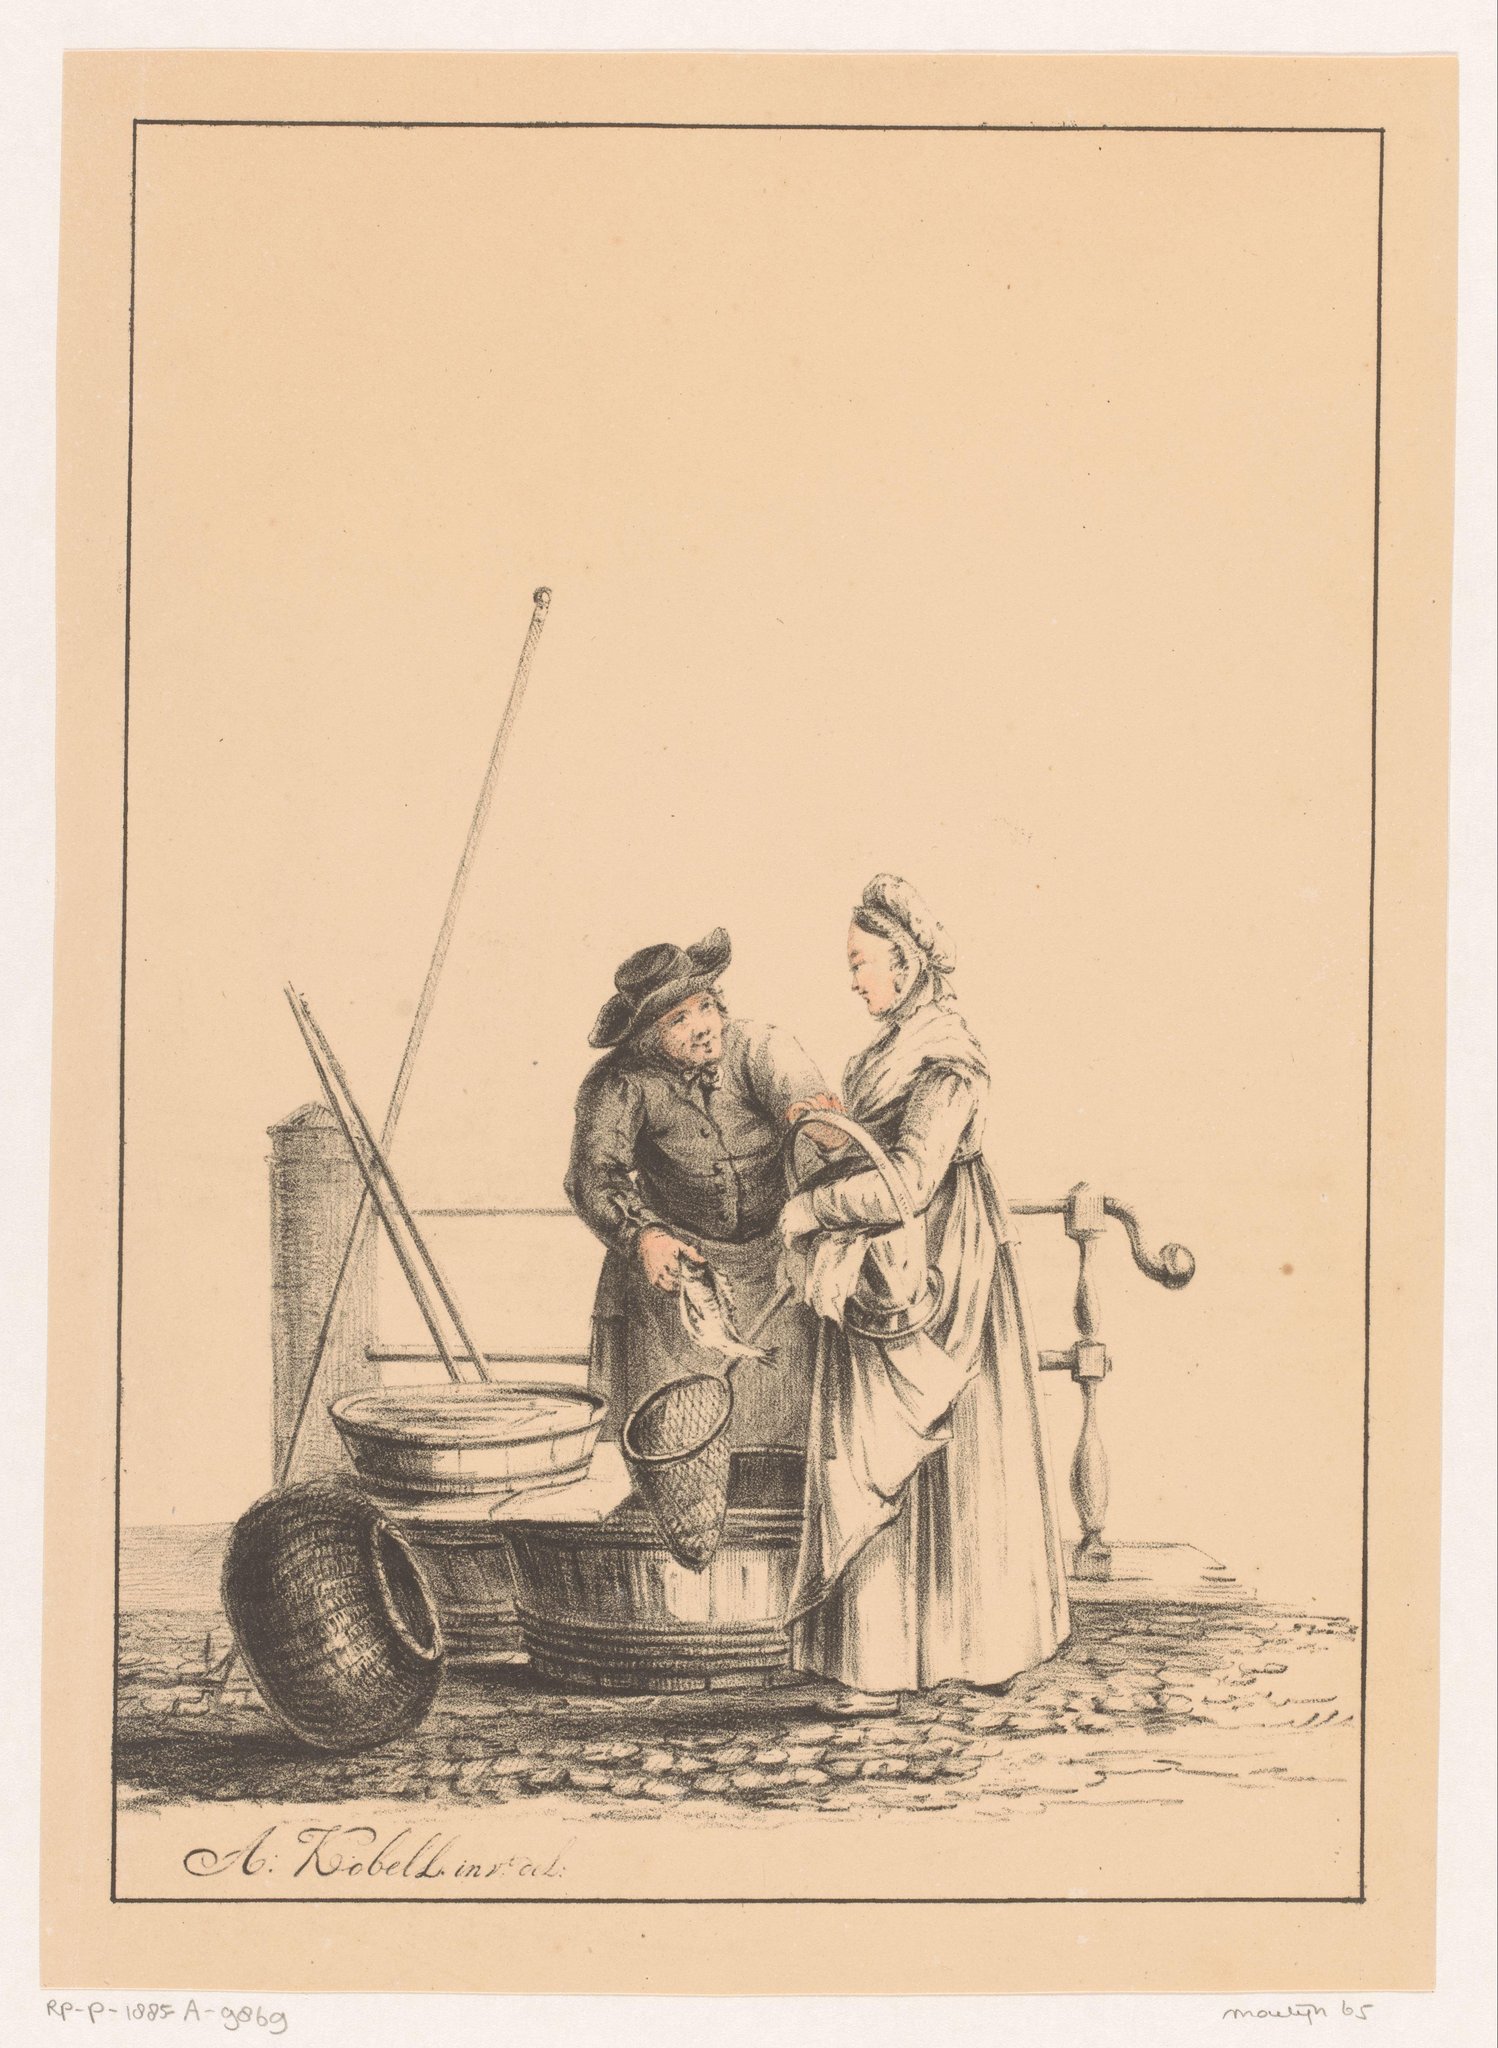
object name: ornament print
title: Amor en putto op een strand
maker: gerrit visscher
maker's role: print maker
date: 1690-1710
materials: paper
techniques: engraving, etching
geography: amsterdam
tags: ornaments ~ art, sailing-ship, sailing-boat, (story of) cupid, amor (eros), cupids: 'amores', 'amoretti', 'putti'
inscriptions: collector's mark: Lugt 2228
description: Amor met boog en putto bij fruitmand op een strand. In het verschiet zeilschepen op zee. De voorstelling is gevat in een ornamenteel kader.